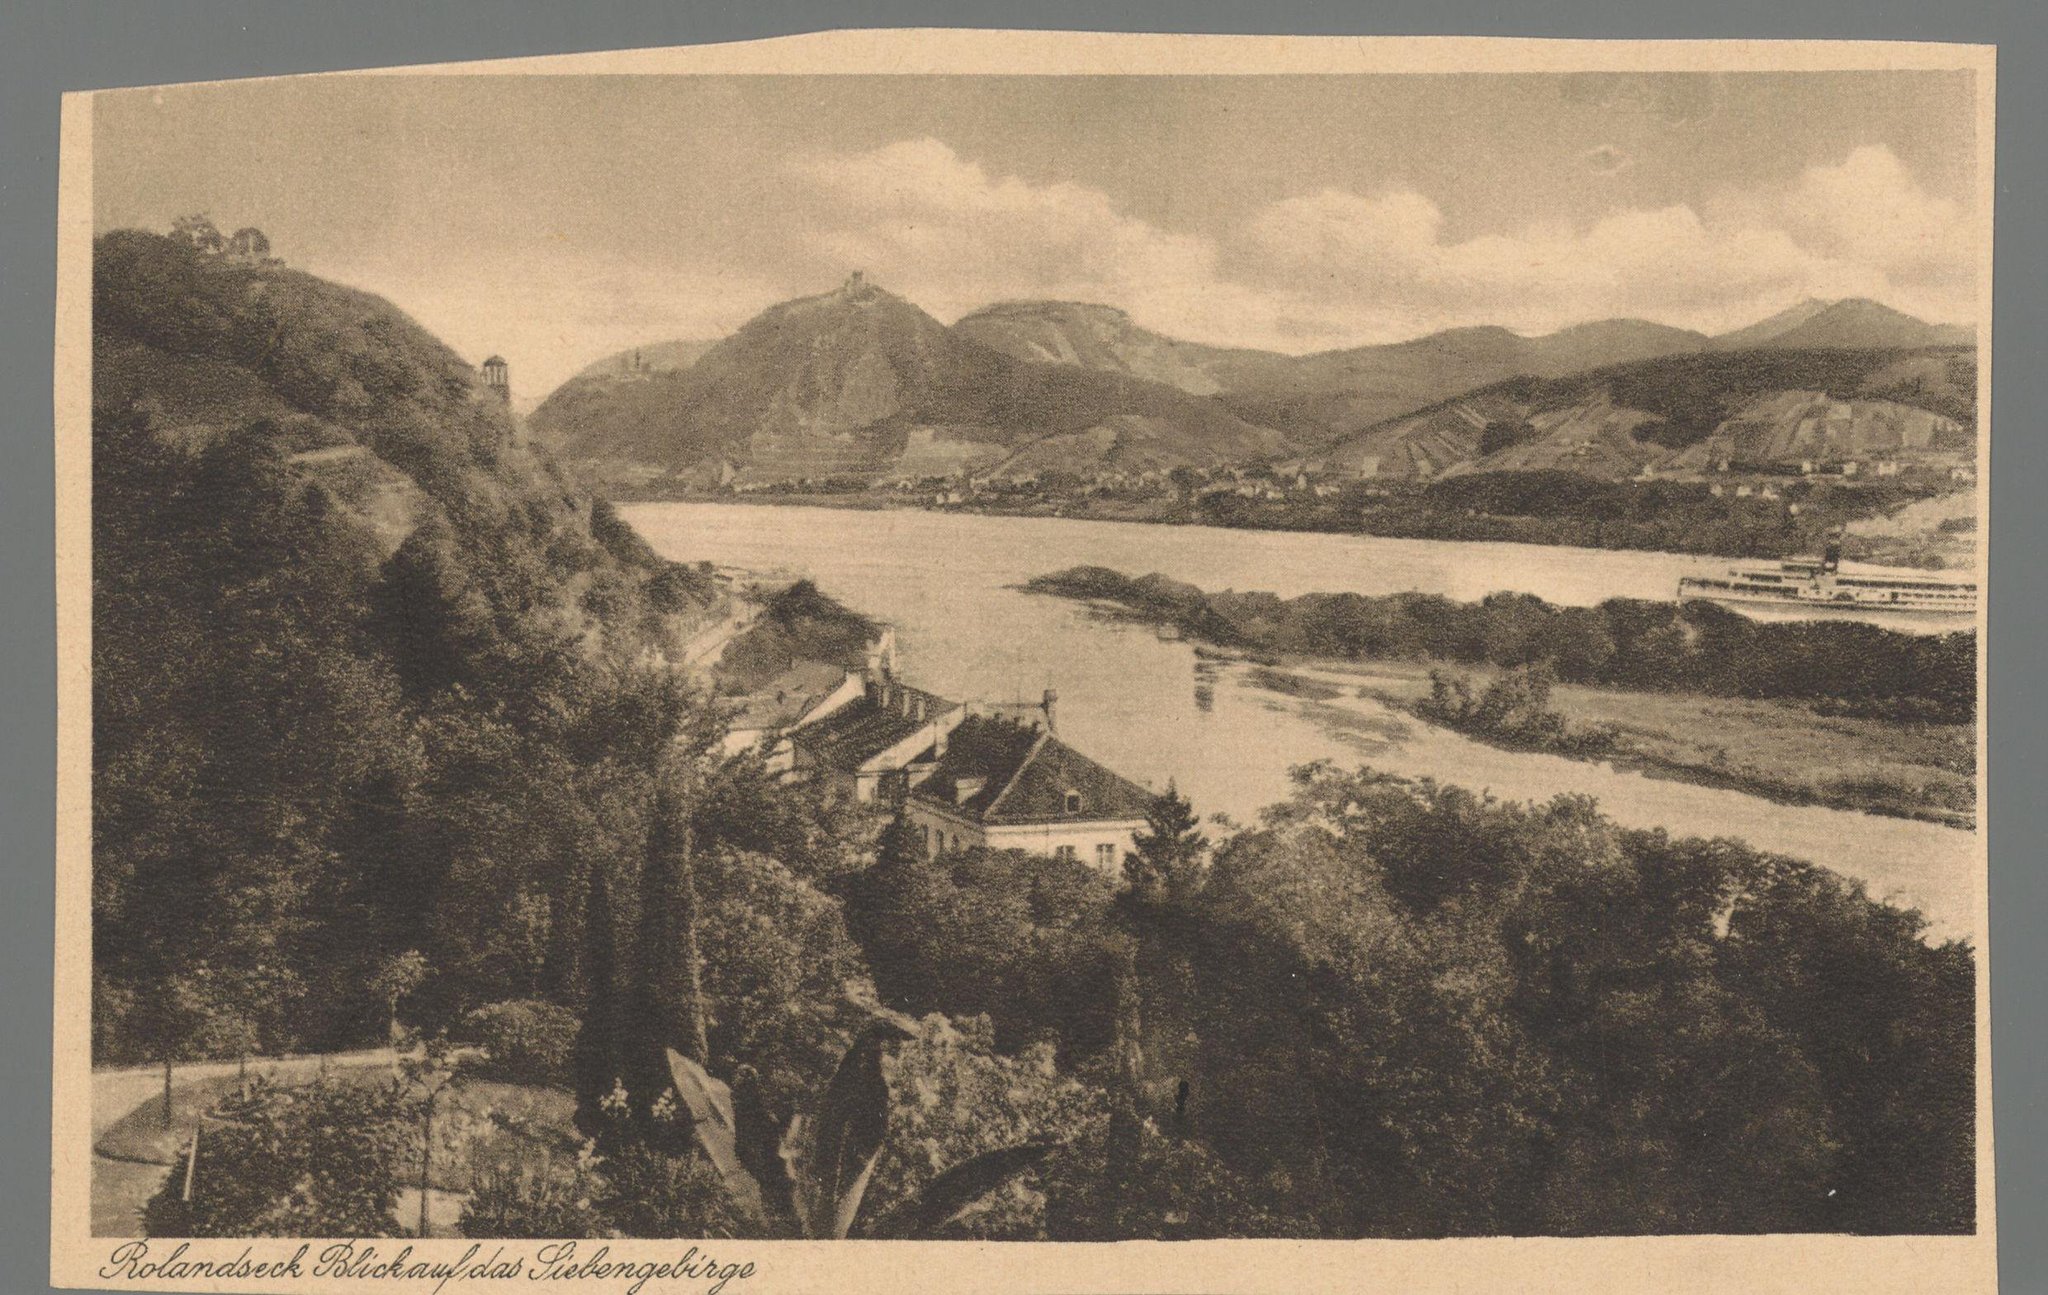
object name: ansichtkaart, prentbriefkaart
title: Rolandseck. Blick auf das Siebengebirge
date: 1905-1930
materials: cardboard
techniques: rotogravure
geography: rolandseck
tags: river, mountains